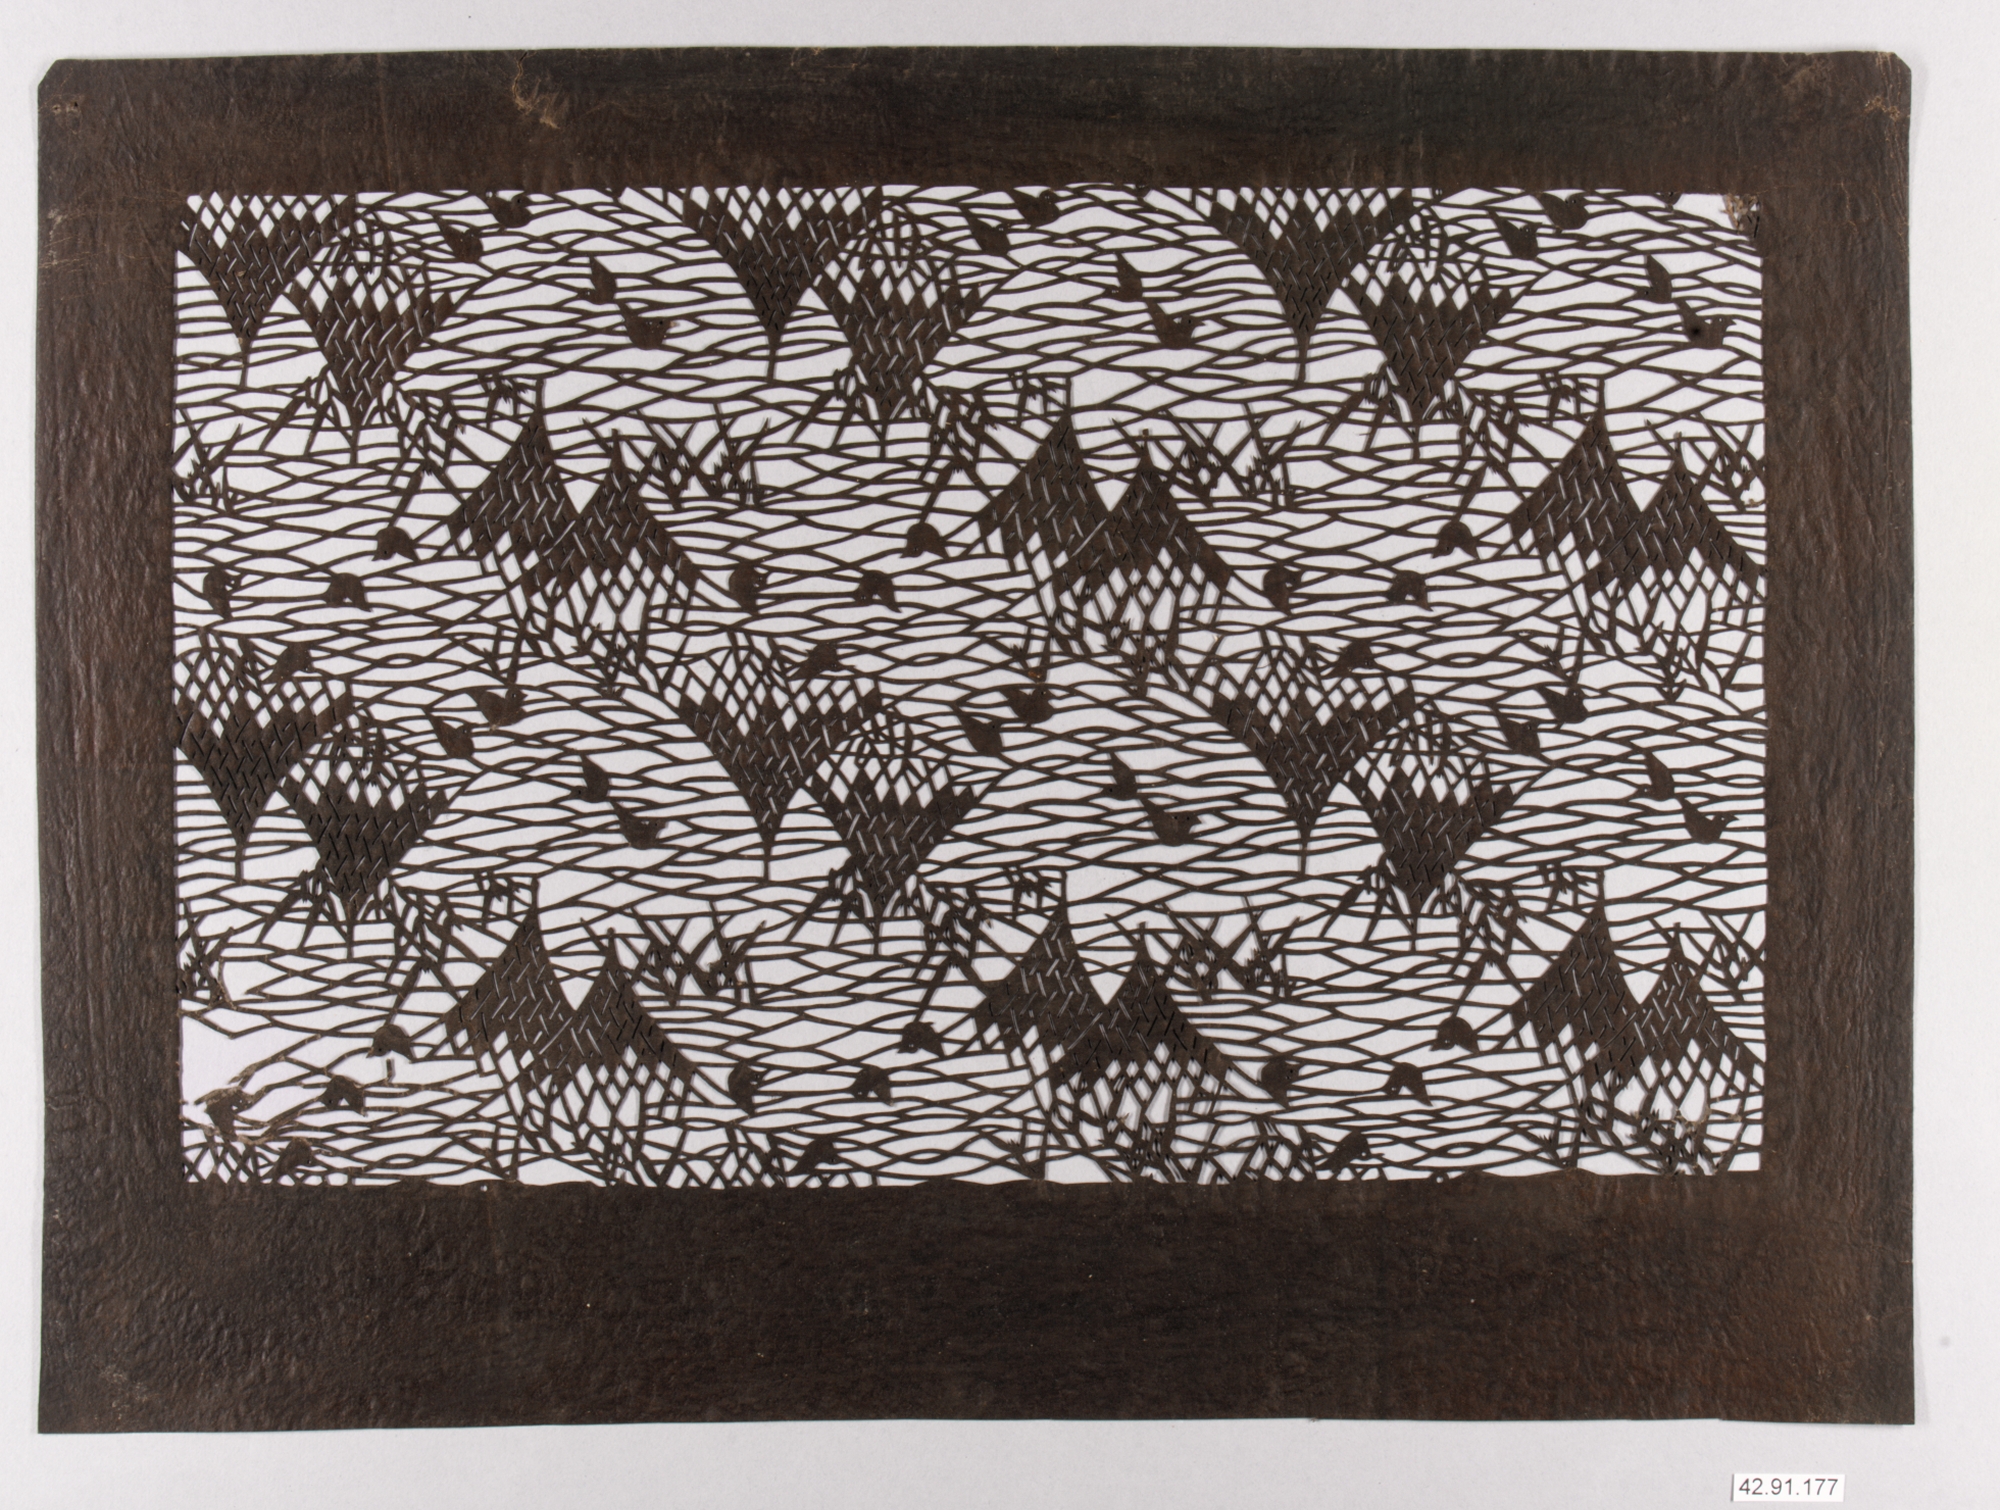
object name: stencil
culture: japanese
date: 1801-1900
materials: paper